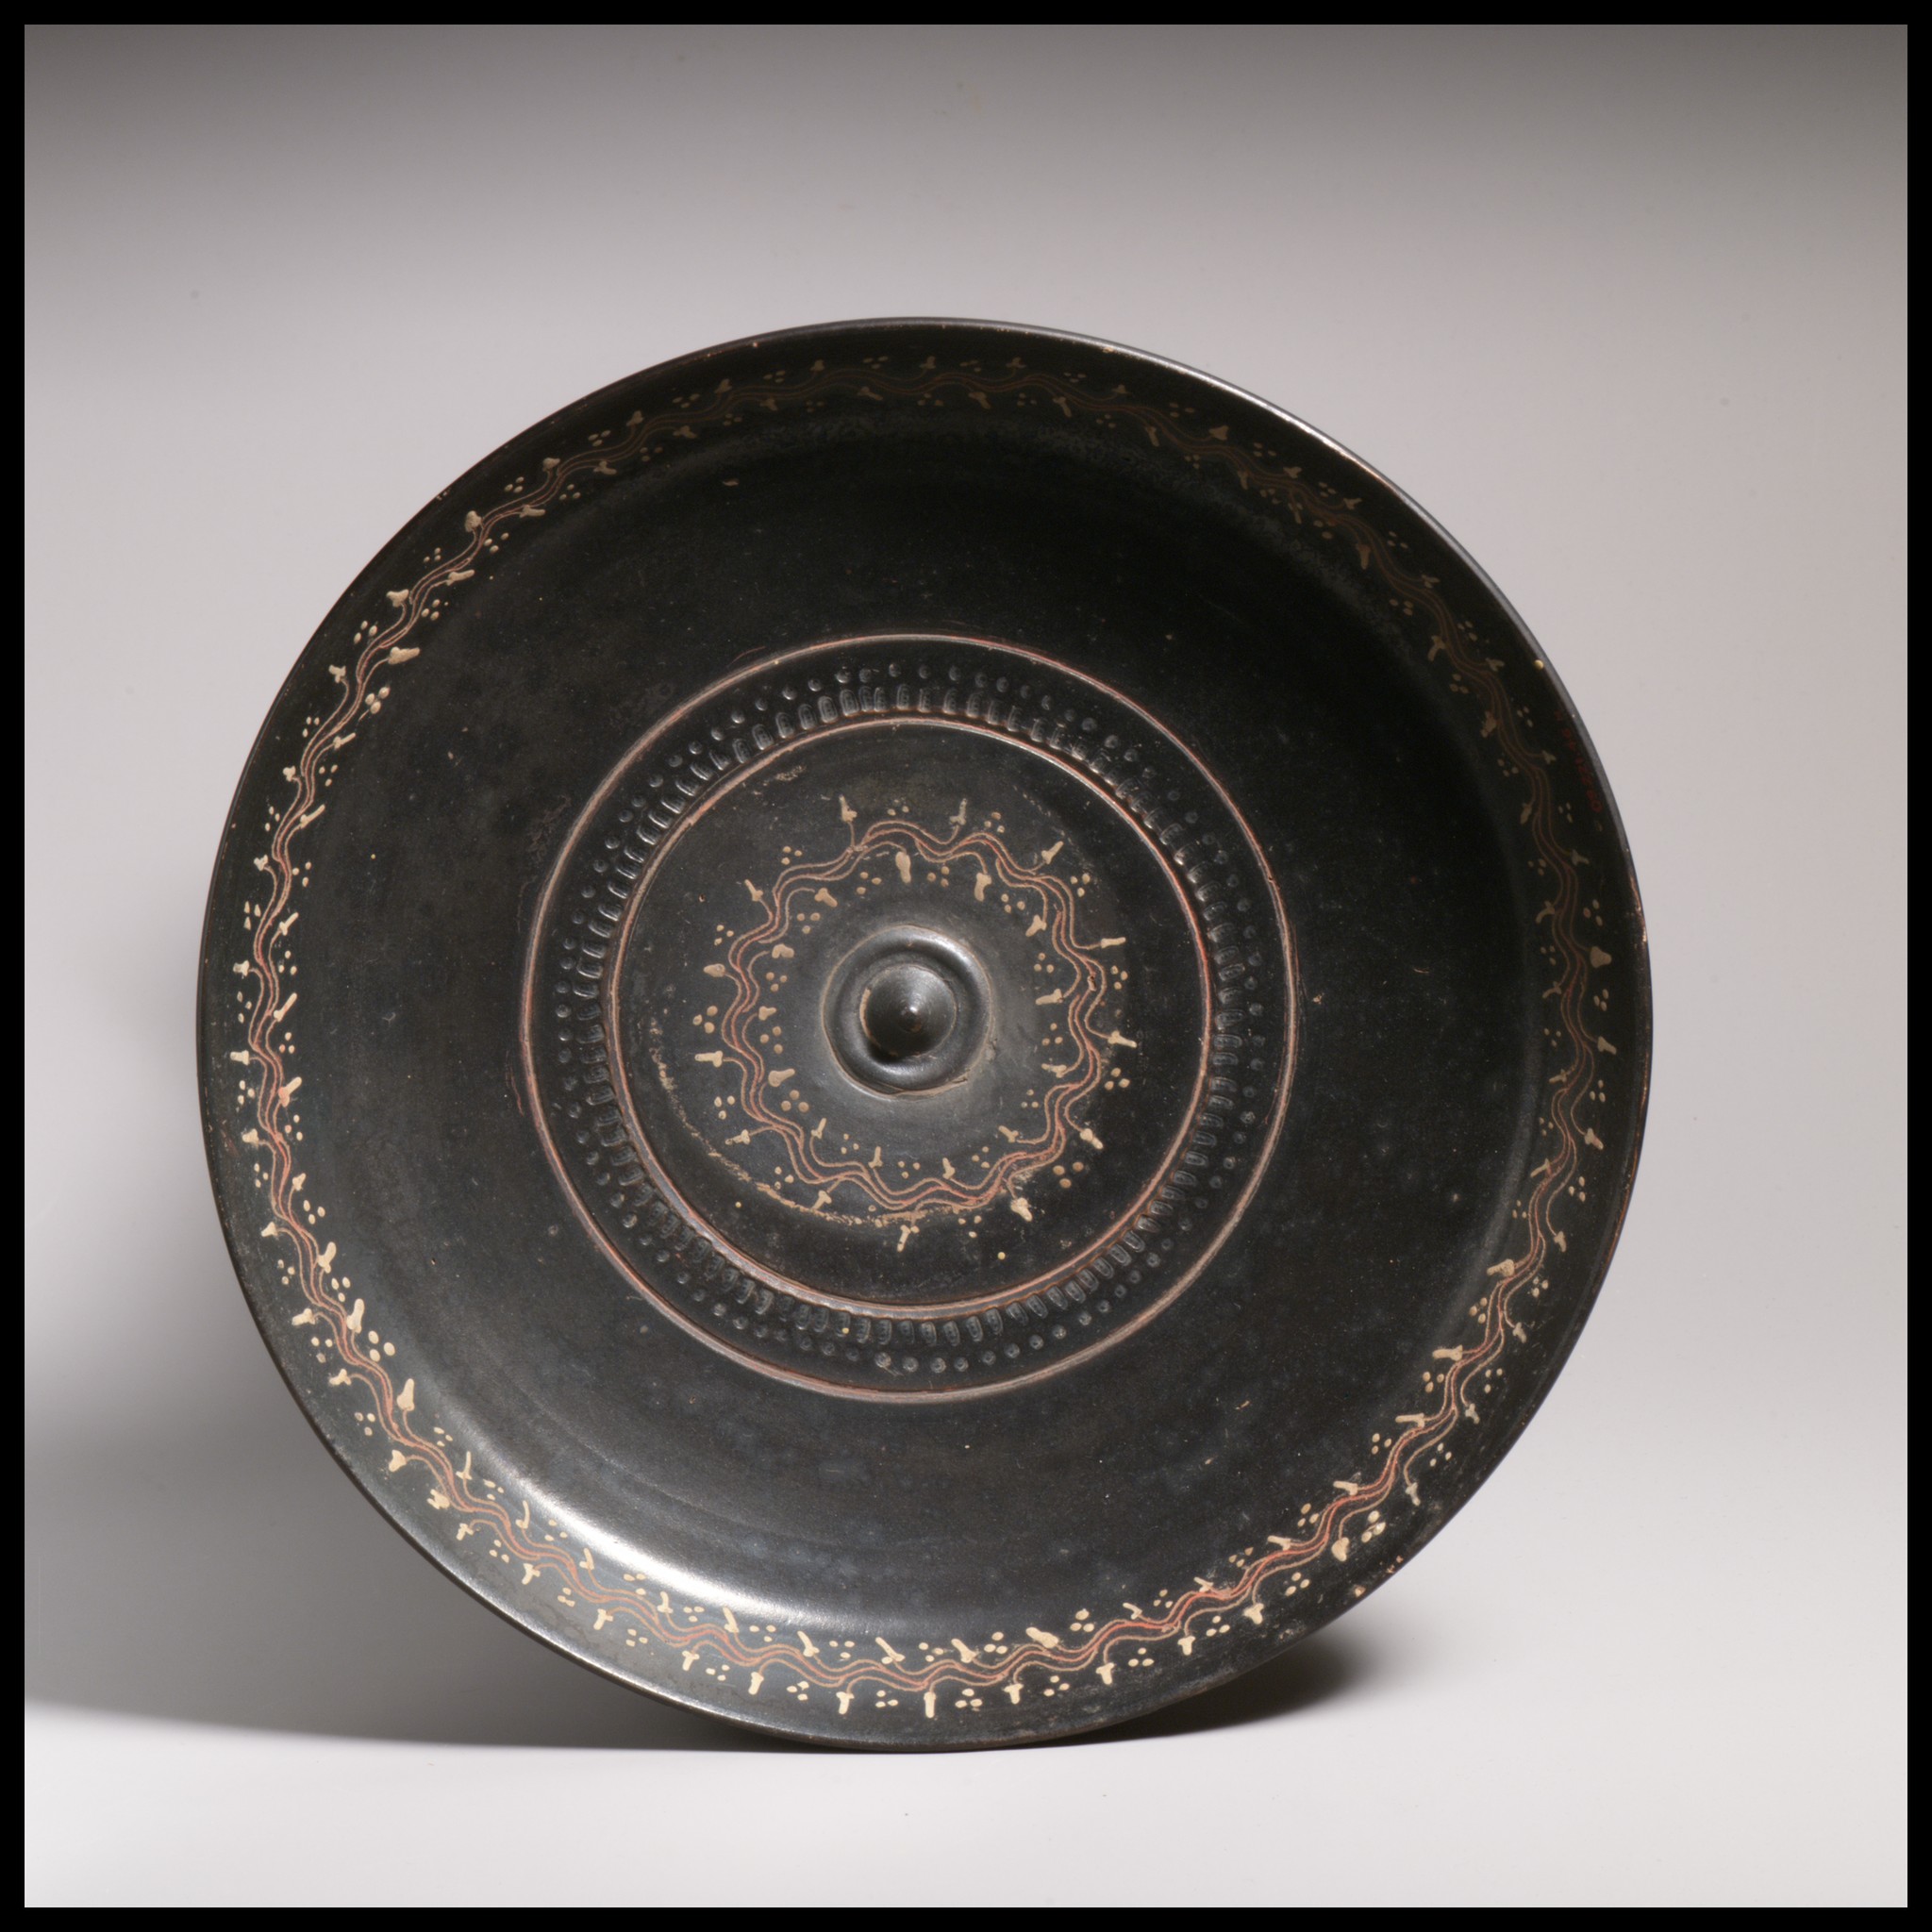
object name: dish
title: Terracotta dish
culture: greek, south italian, campanian, teano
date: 330-300 BCE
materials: terracotta